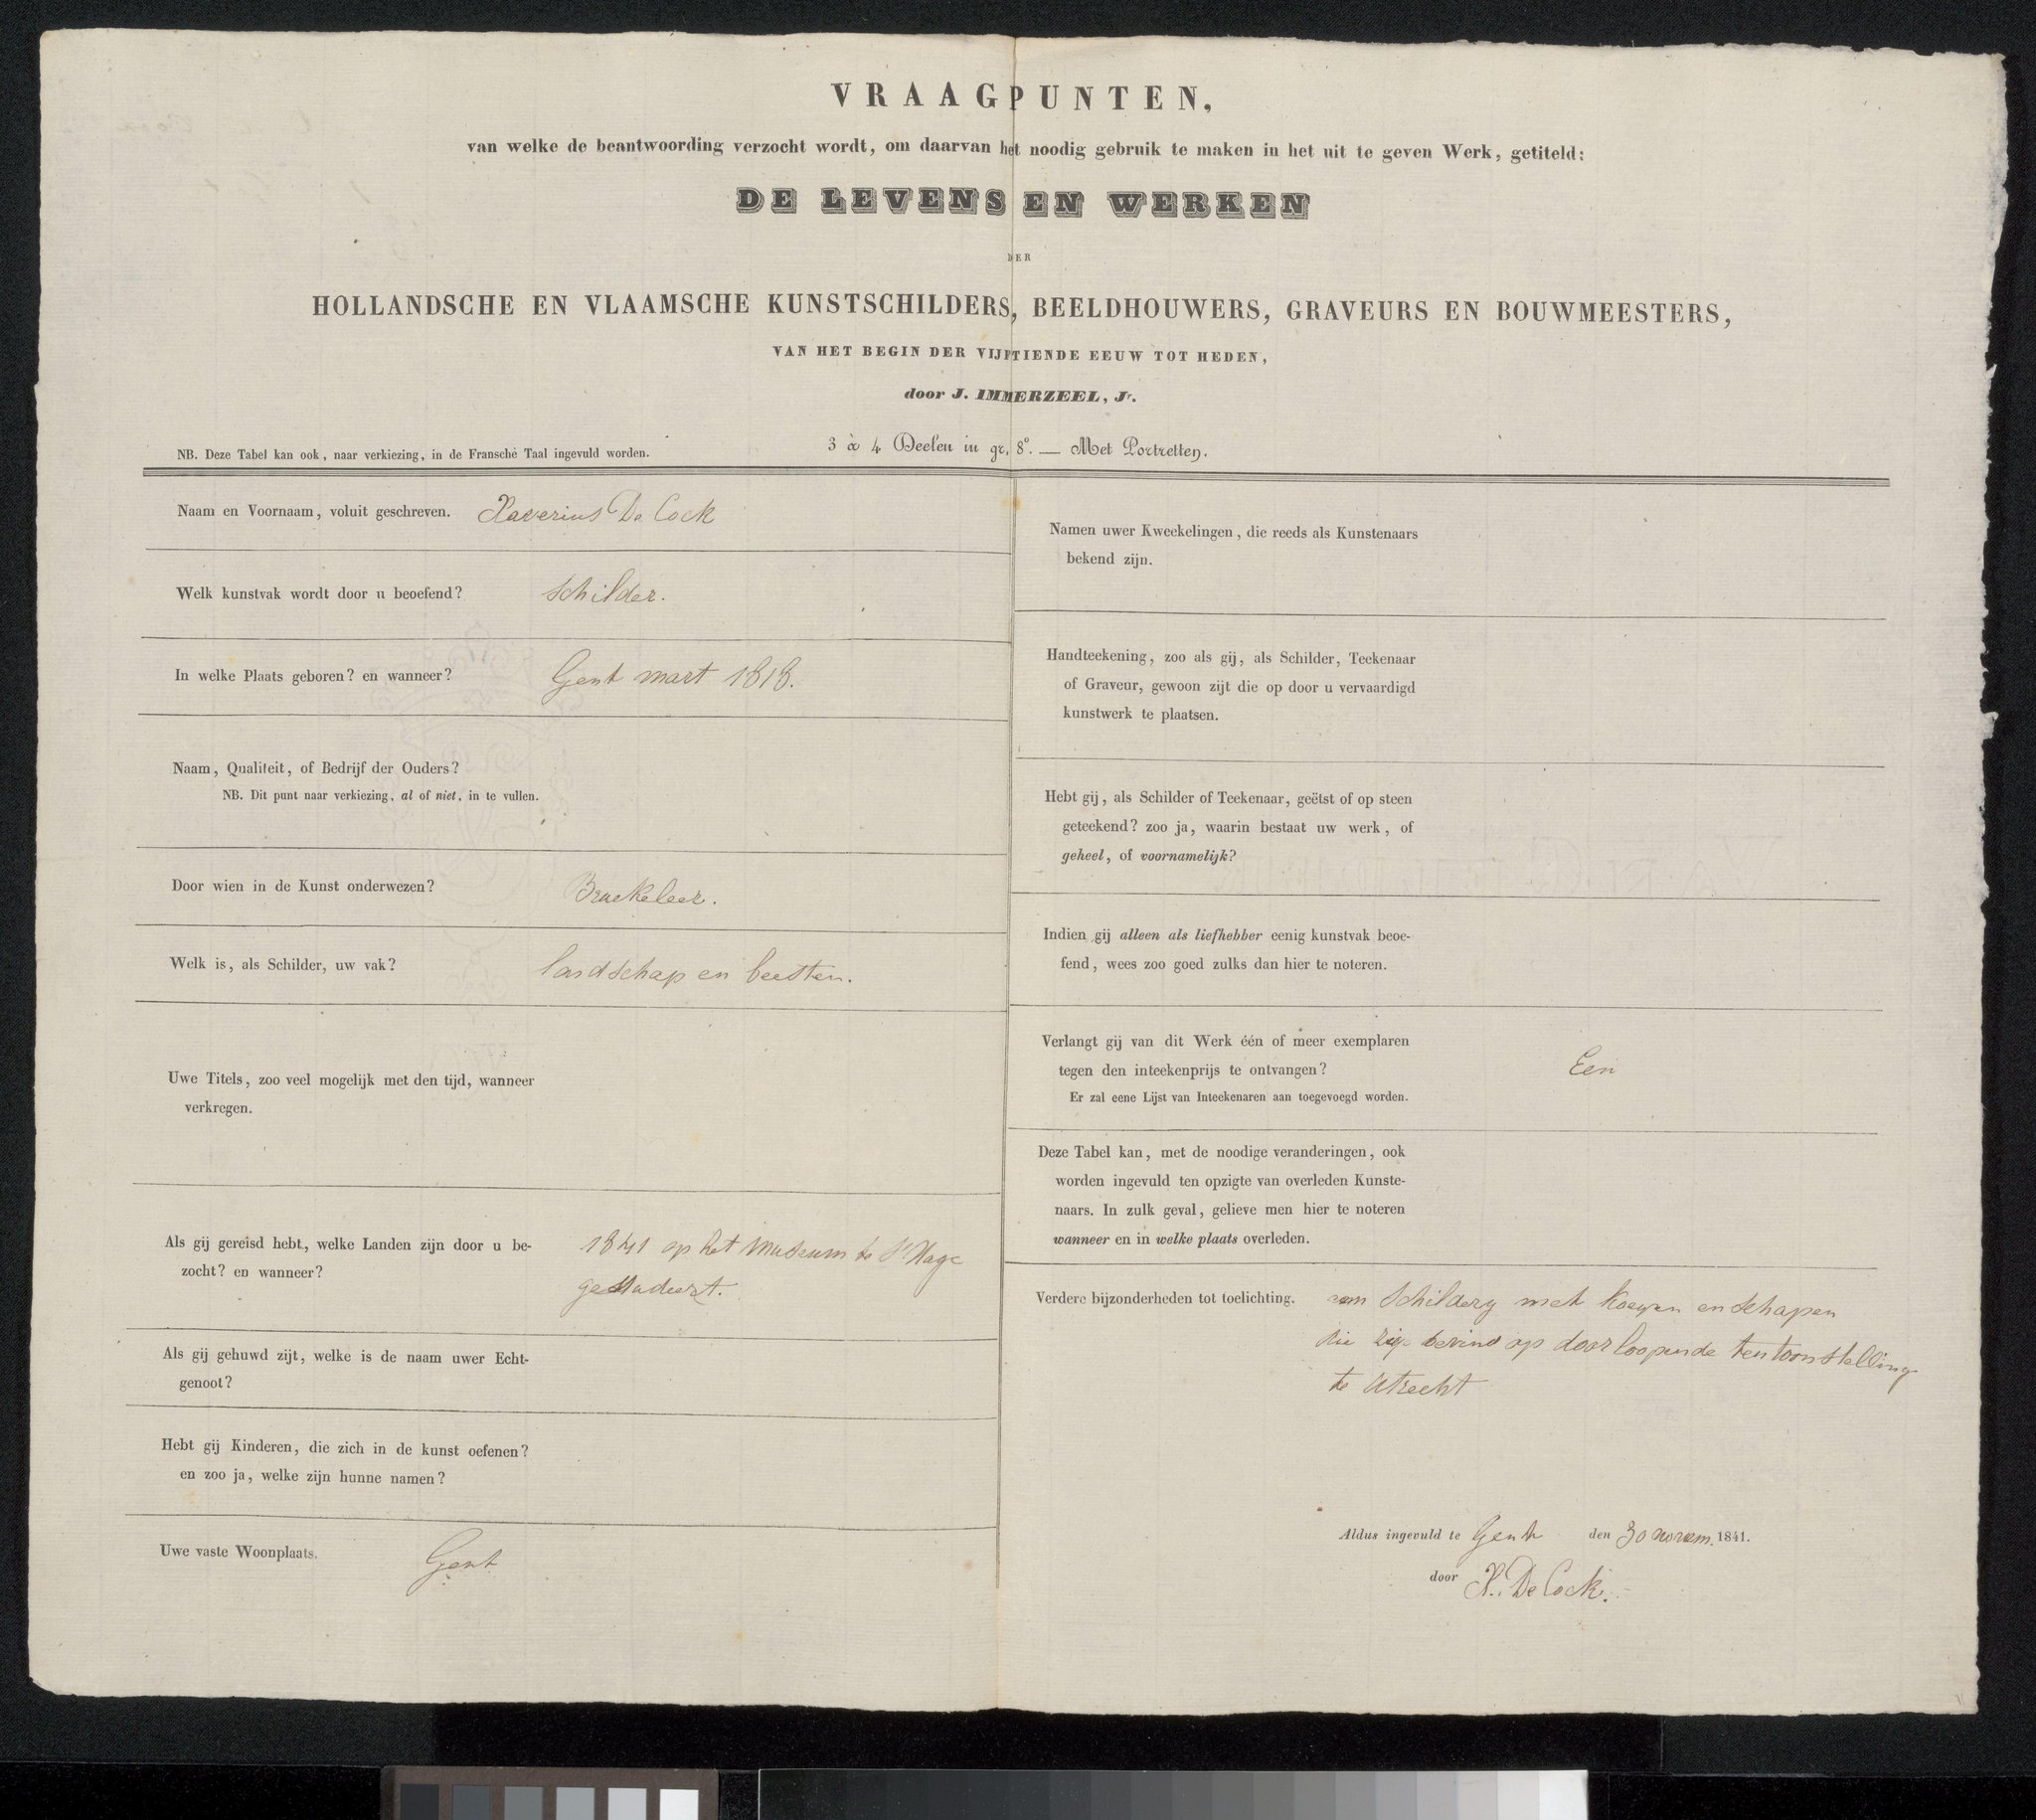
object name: questionnaire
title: Enquêteformulier ingevuld door Xavier De Cock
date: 1841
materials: ink, paper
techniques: pen, printing, writing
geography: ghent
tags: ghent, painter, xavier de cock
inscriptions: inscription: ‘Vraagpunten,/ van welke de beantwoording verzocht wordt, om daarvan het noodig gebruik te maken in het uit te geven Werk, getiteld: De levens en werken/ der Hollandsche en Vlaamsche kunstschilders, beeldhouwers,/ graveurs en bouwmeesters, van het begin der vijftiende eeuw tot heden/ door J. Immerzeel, Jr.’, watermark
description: Opgenomen in: Immerzeel, J. Jr., De levens en werken der Hollandsche en Vlaamsche kunstschilders, beeldhouwers, graveurs en bouwmeesters, van het begin der vijftiende eeuw tot heden, Amsterdam: J.C. van Kesteren, 1842-1843.